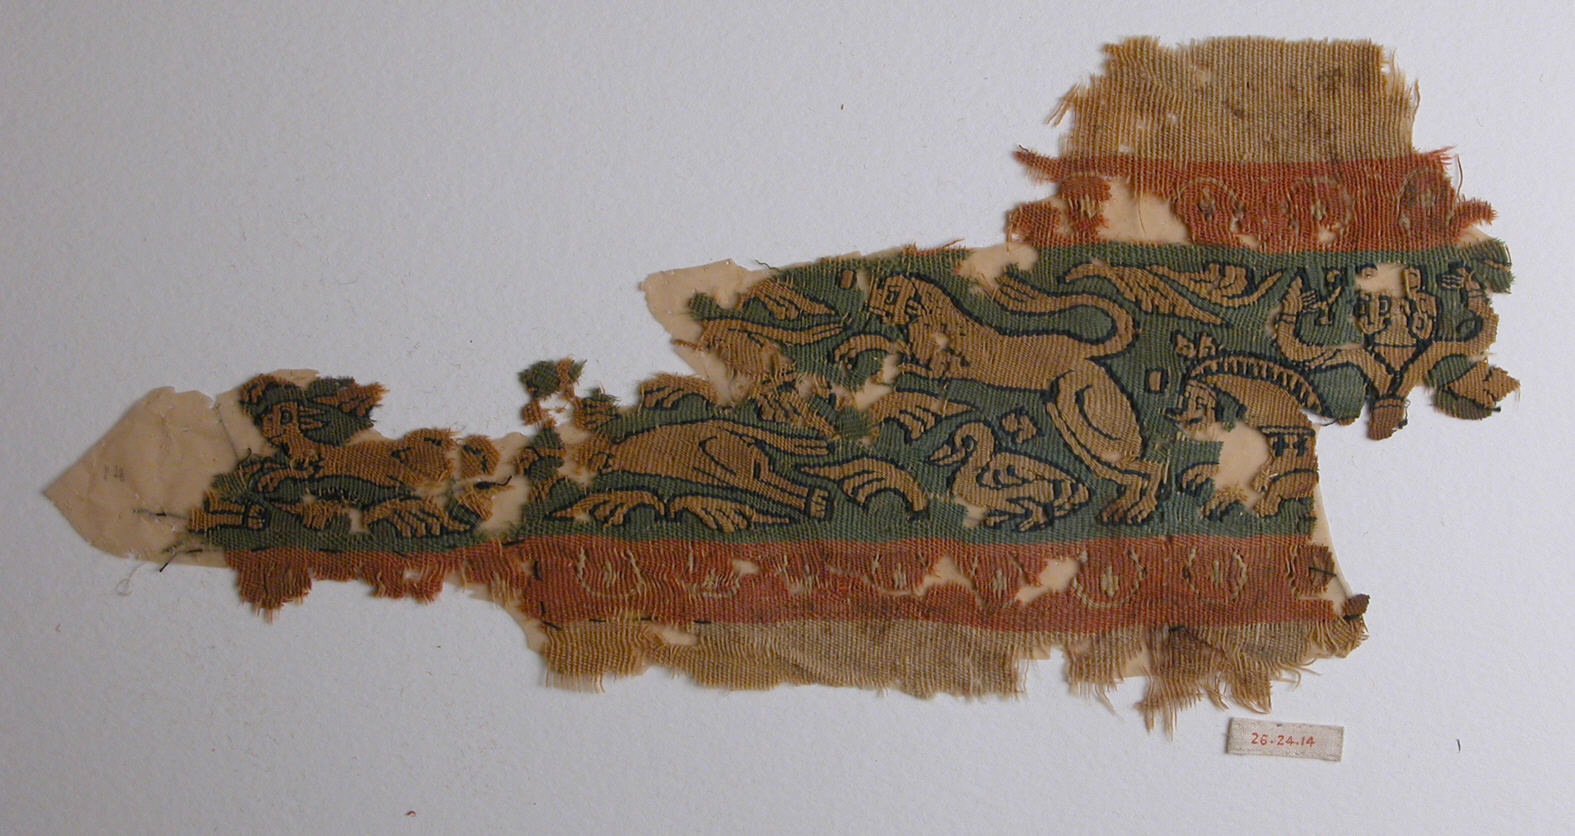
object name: fragment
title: Textile Fragment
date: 401-600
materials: wool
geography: egypt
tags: animals